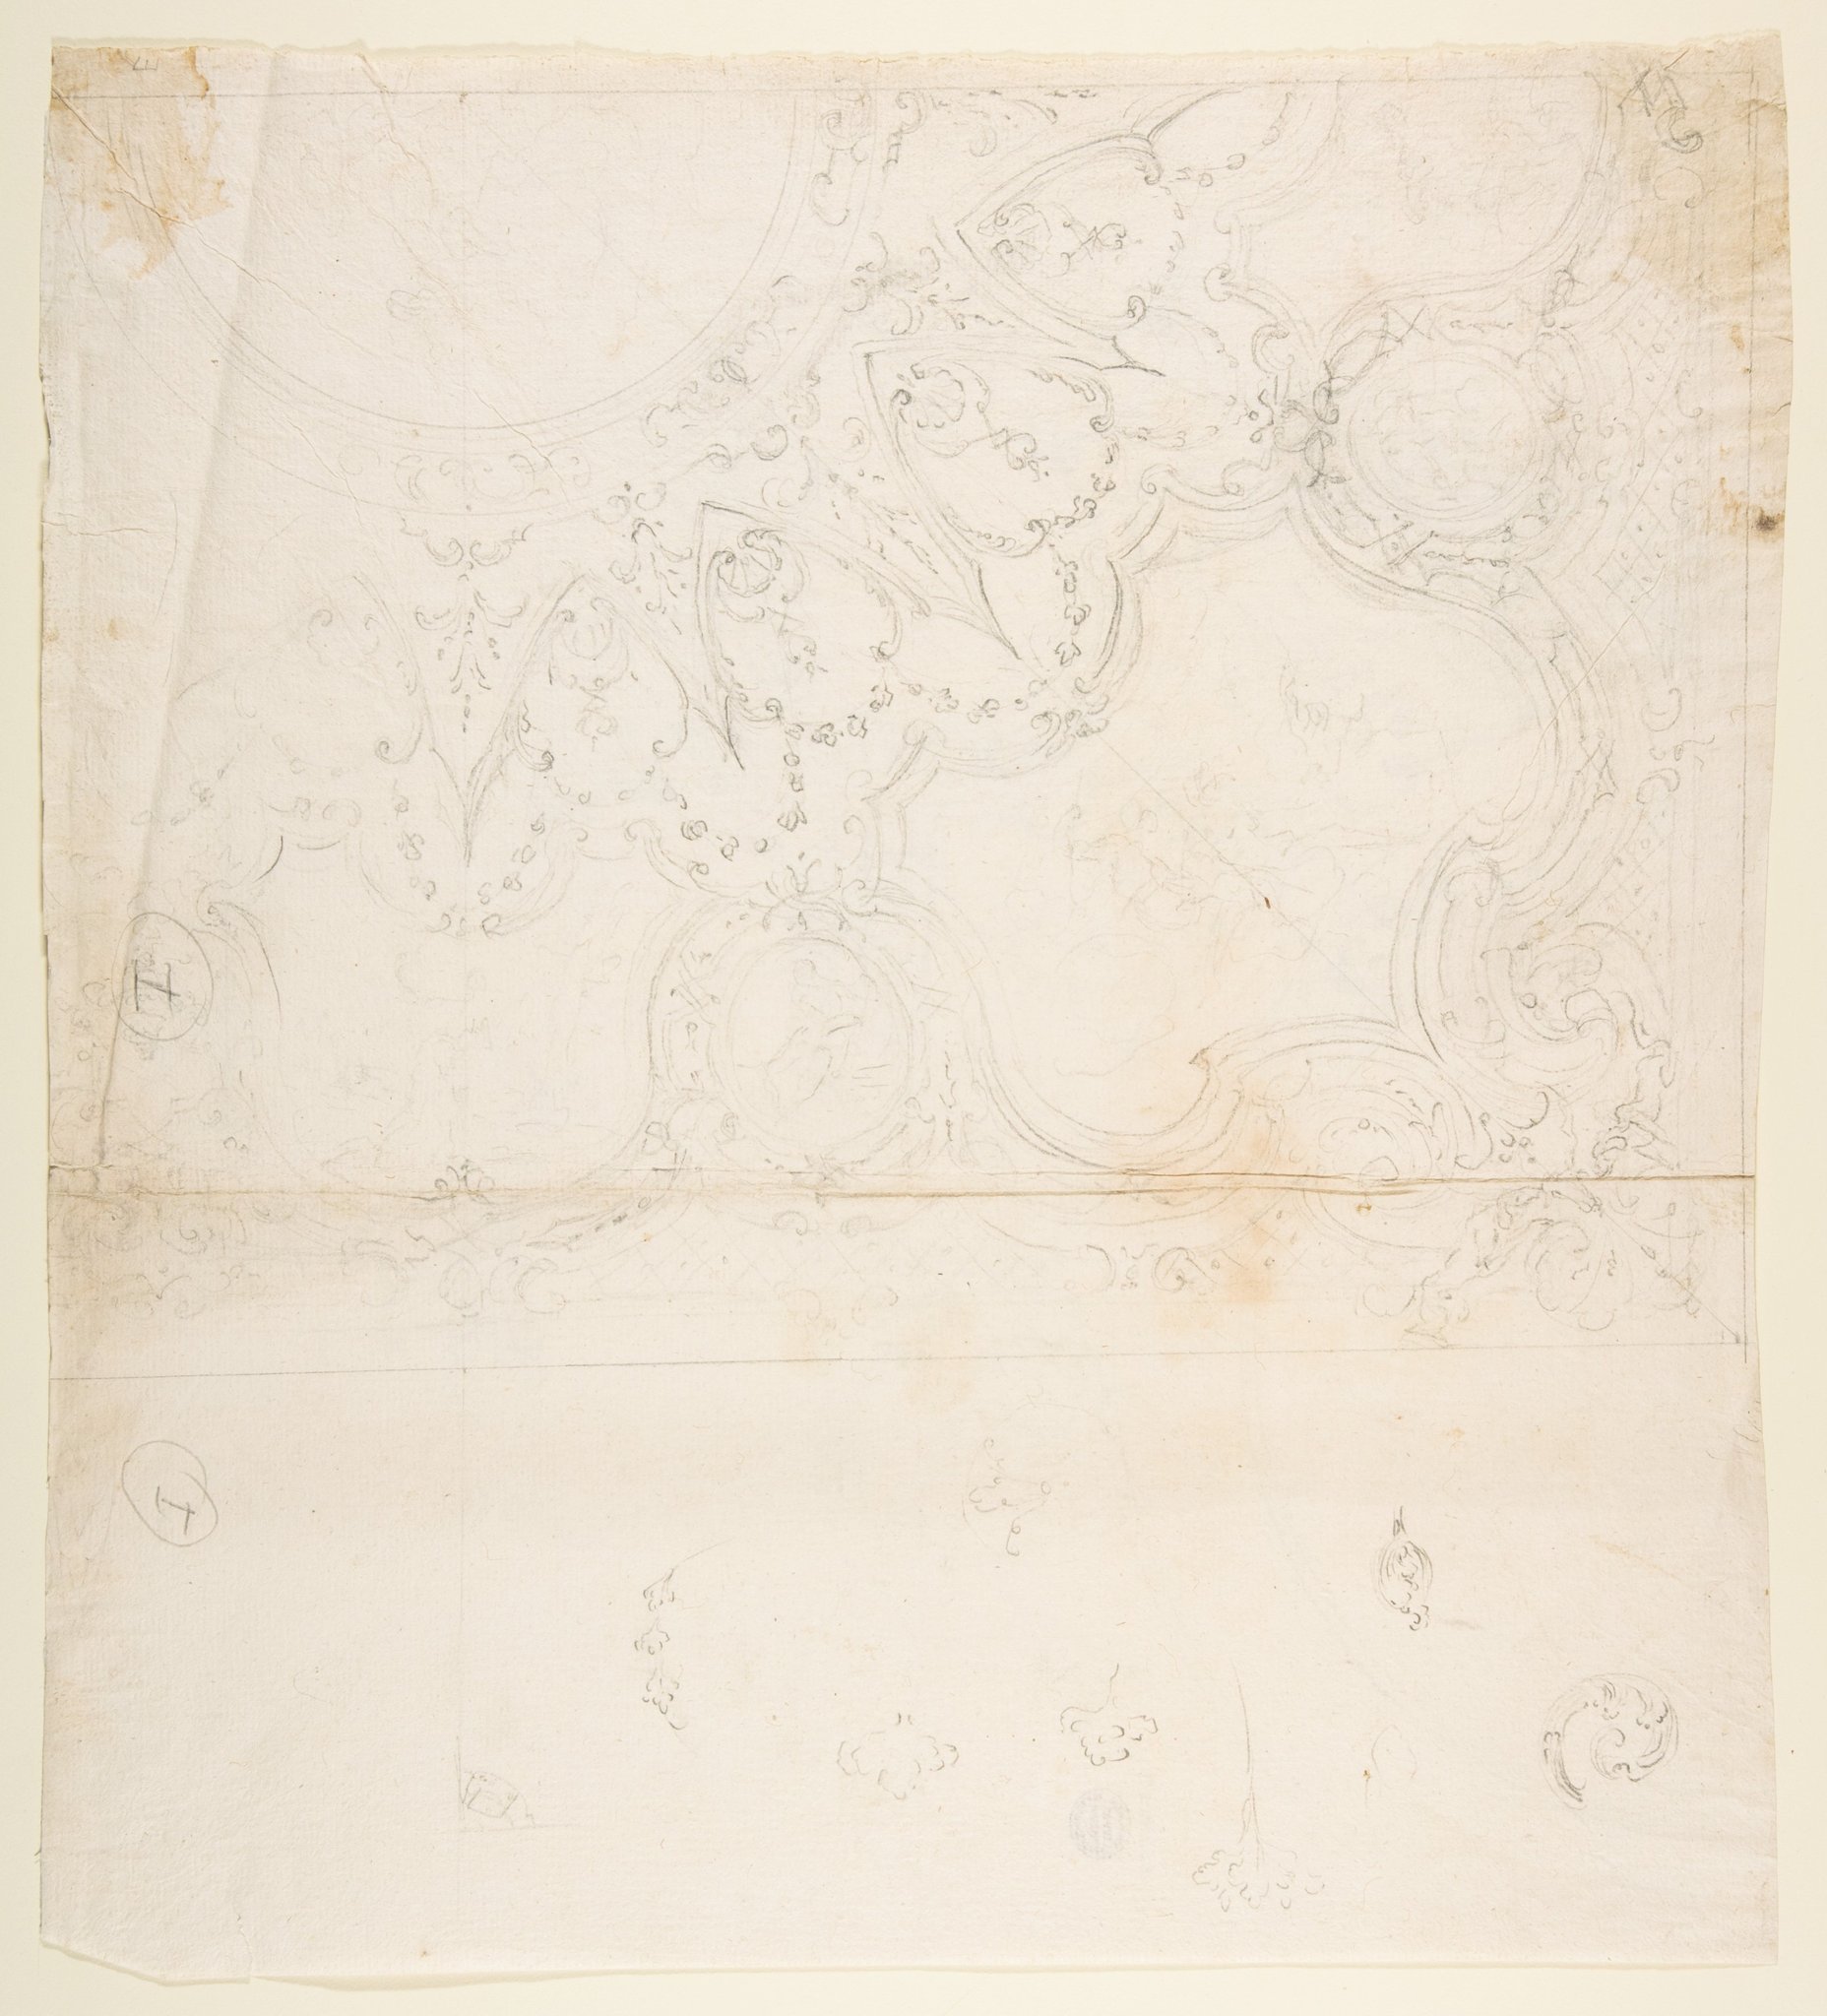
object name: drawing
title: Design for One Quarter of a Ceiling with a Medallion at the Center (recto); Design for a Quarter of a Ceiling with a Medallion at the Corner and a Medallion at the Center (verso)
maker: leonardo marini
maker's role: artist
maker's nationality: italian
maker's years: 1730-1797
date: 1701-1800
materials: graphite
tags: ceilings